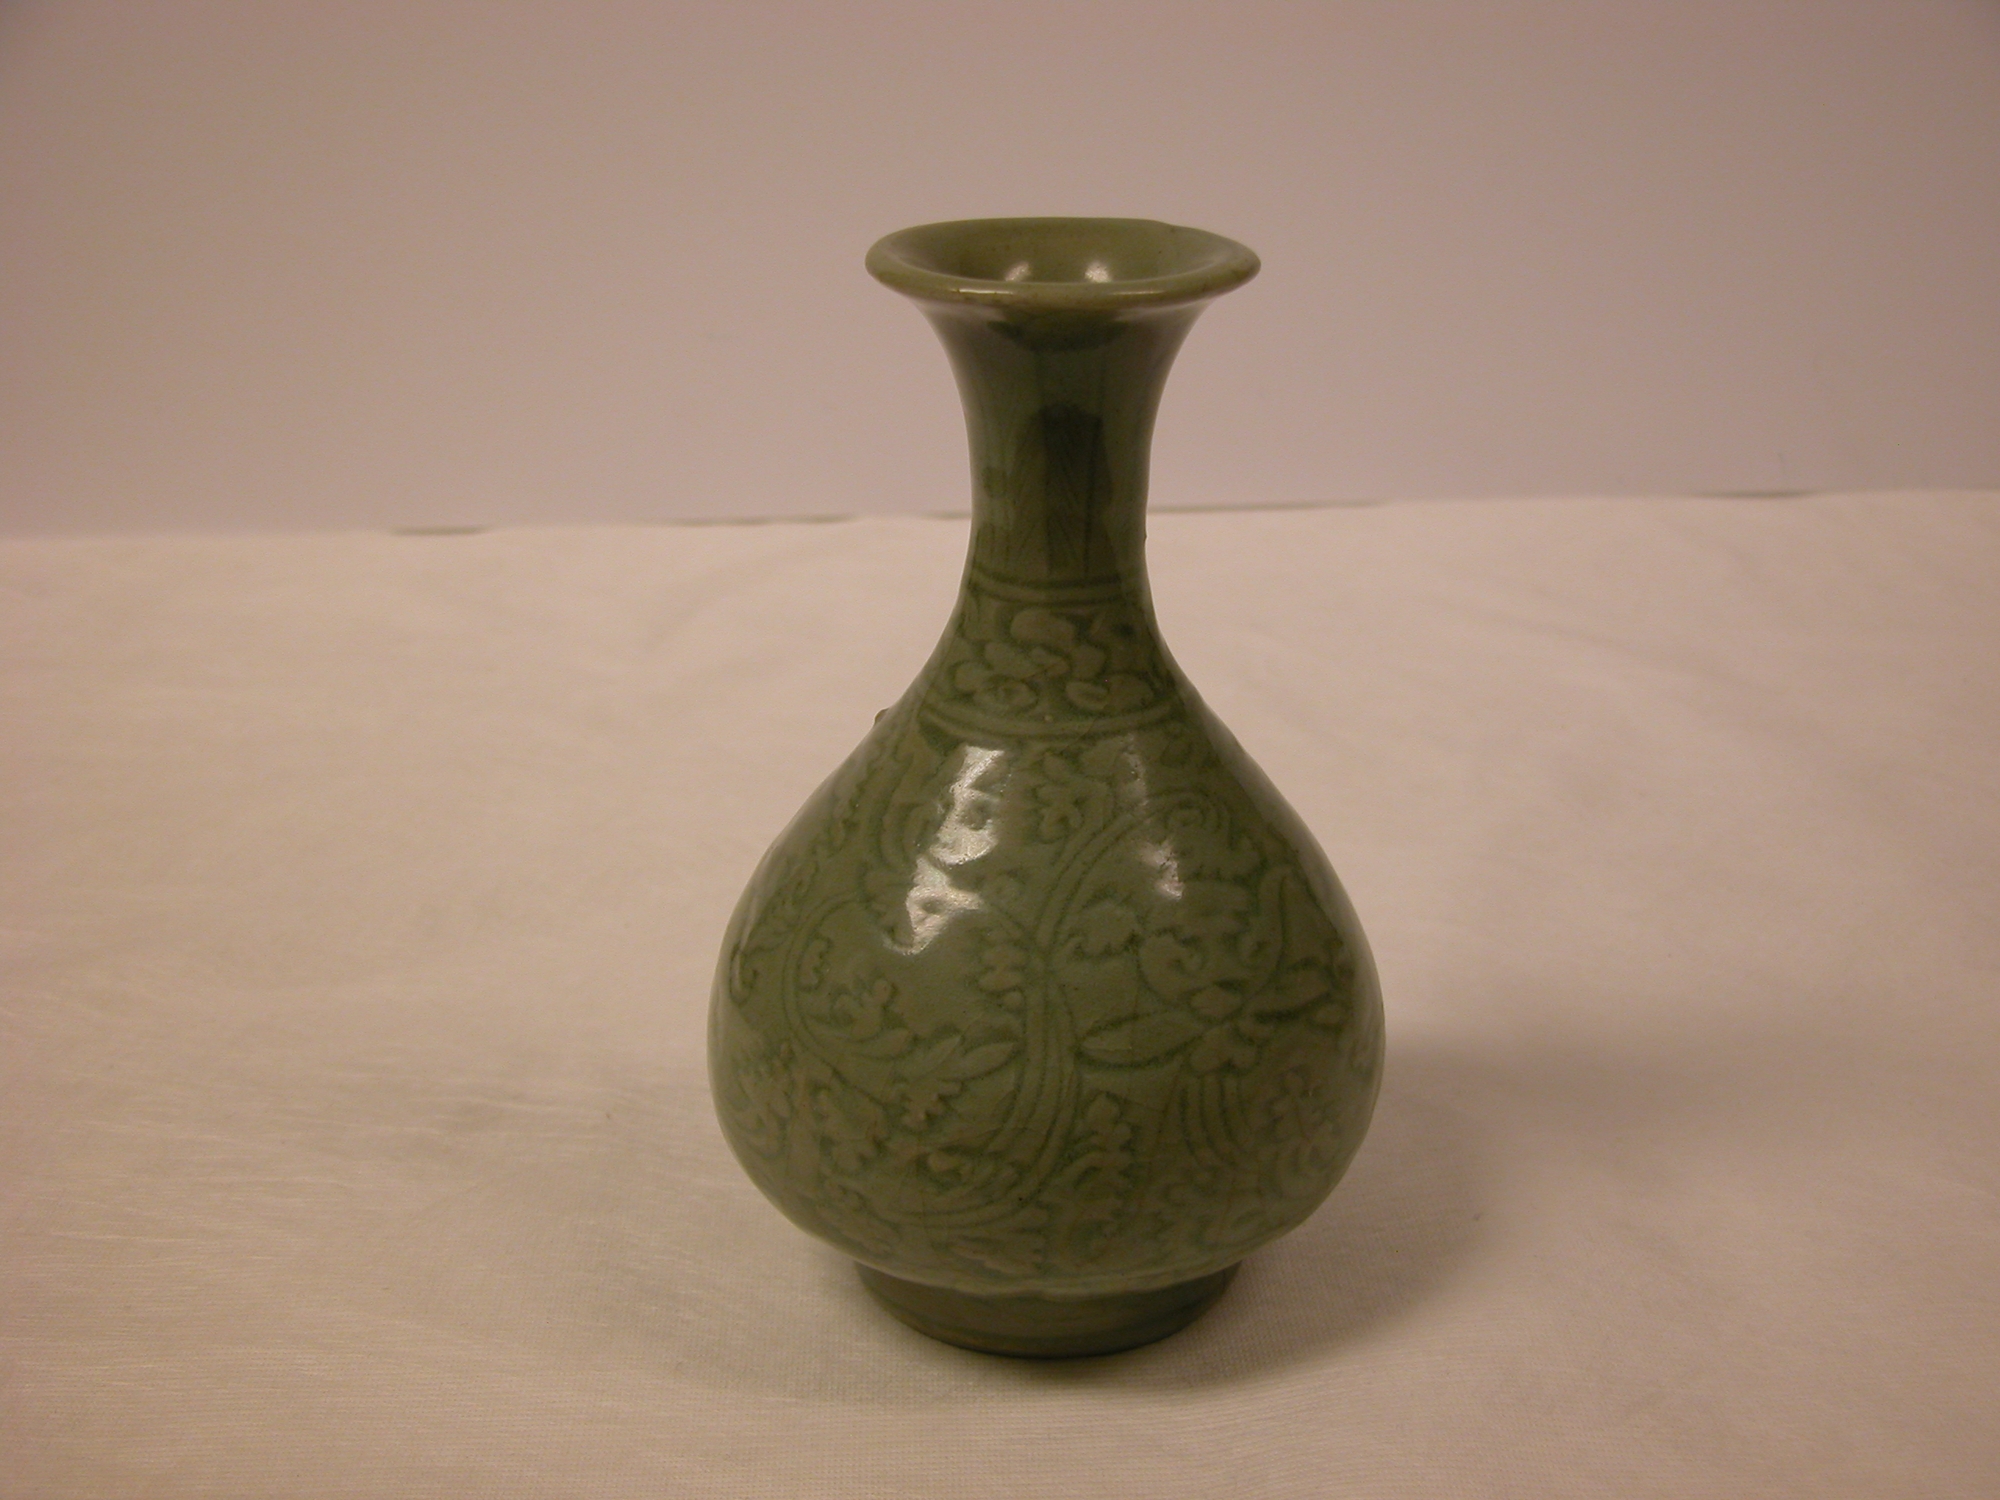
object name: vase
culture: chinese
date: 1401-1600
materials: ceramic glaze, glaze, stoneware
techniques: incising